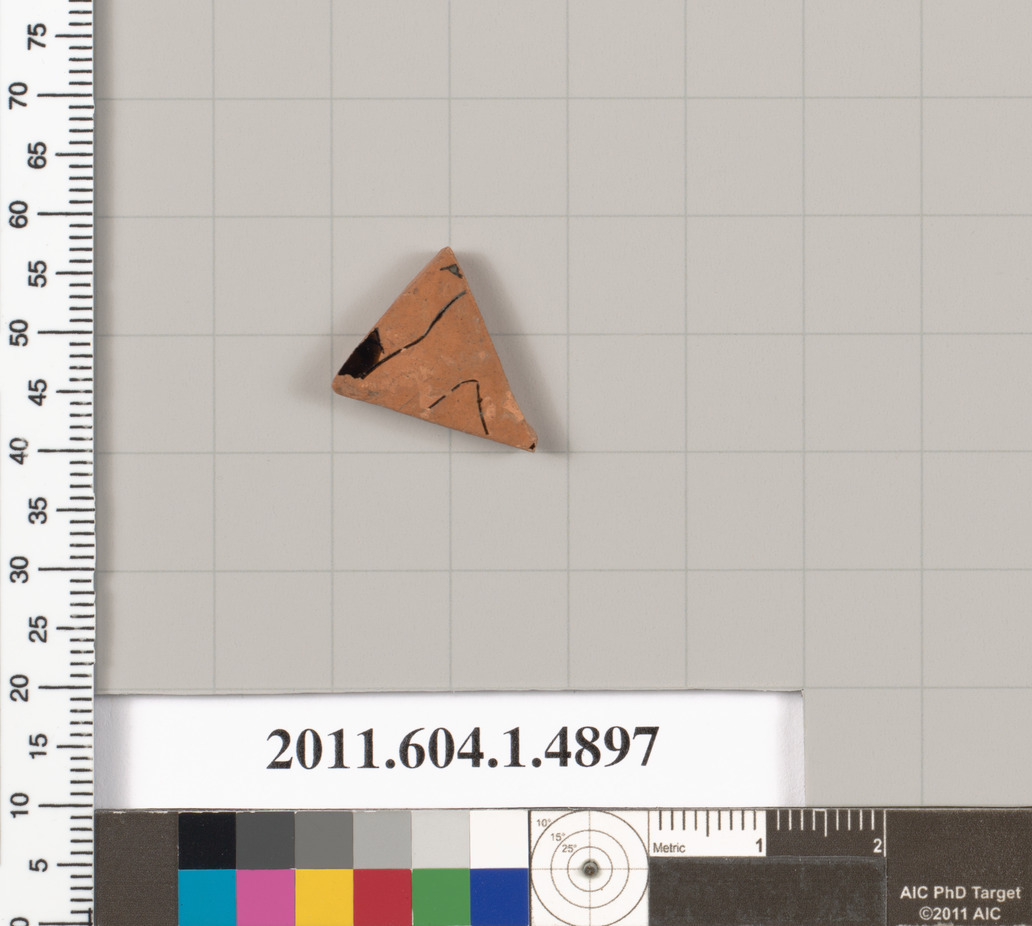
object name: kylix fragment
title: Terracotta fragment of a kylix (drinking cup)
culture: greek, attic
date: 490-480 BCE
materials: terracotta